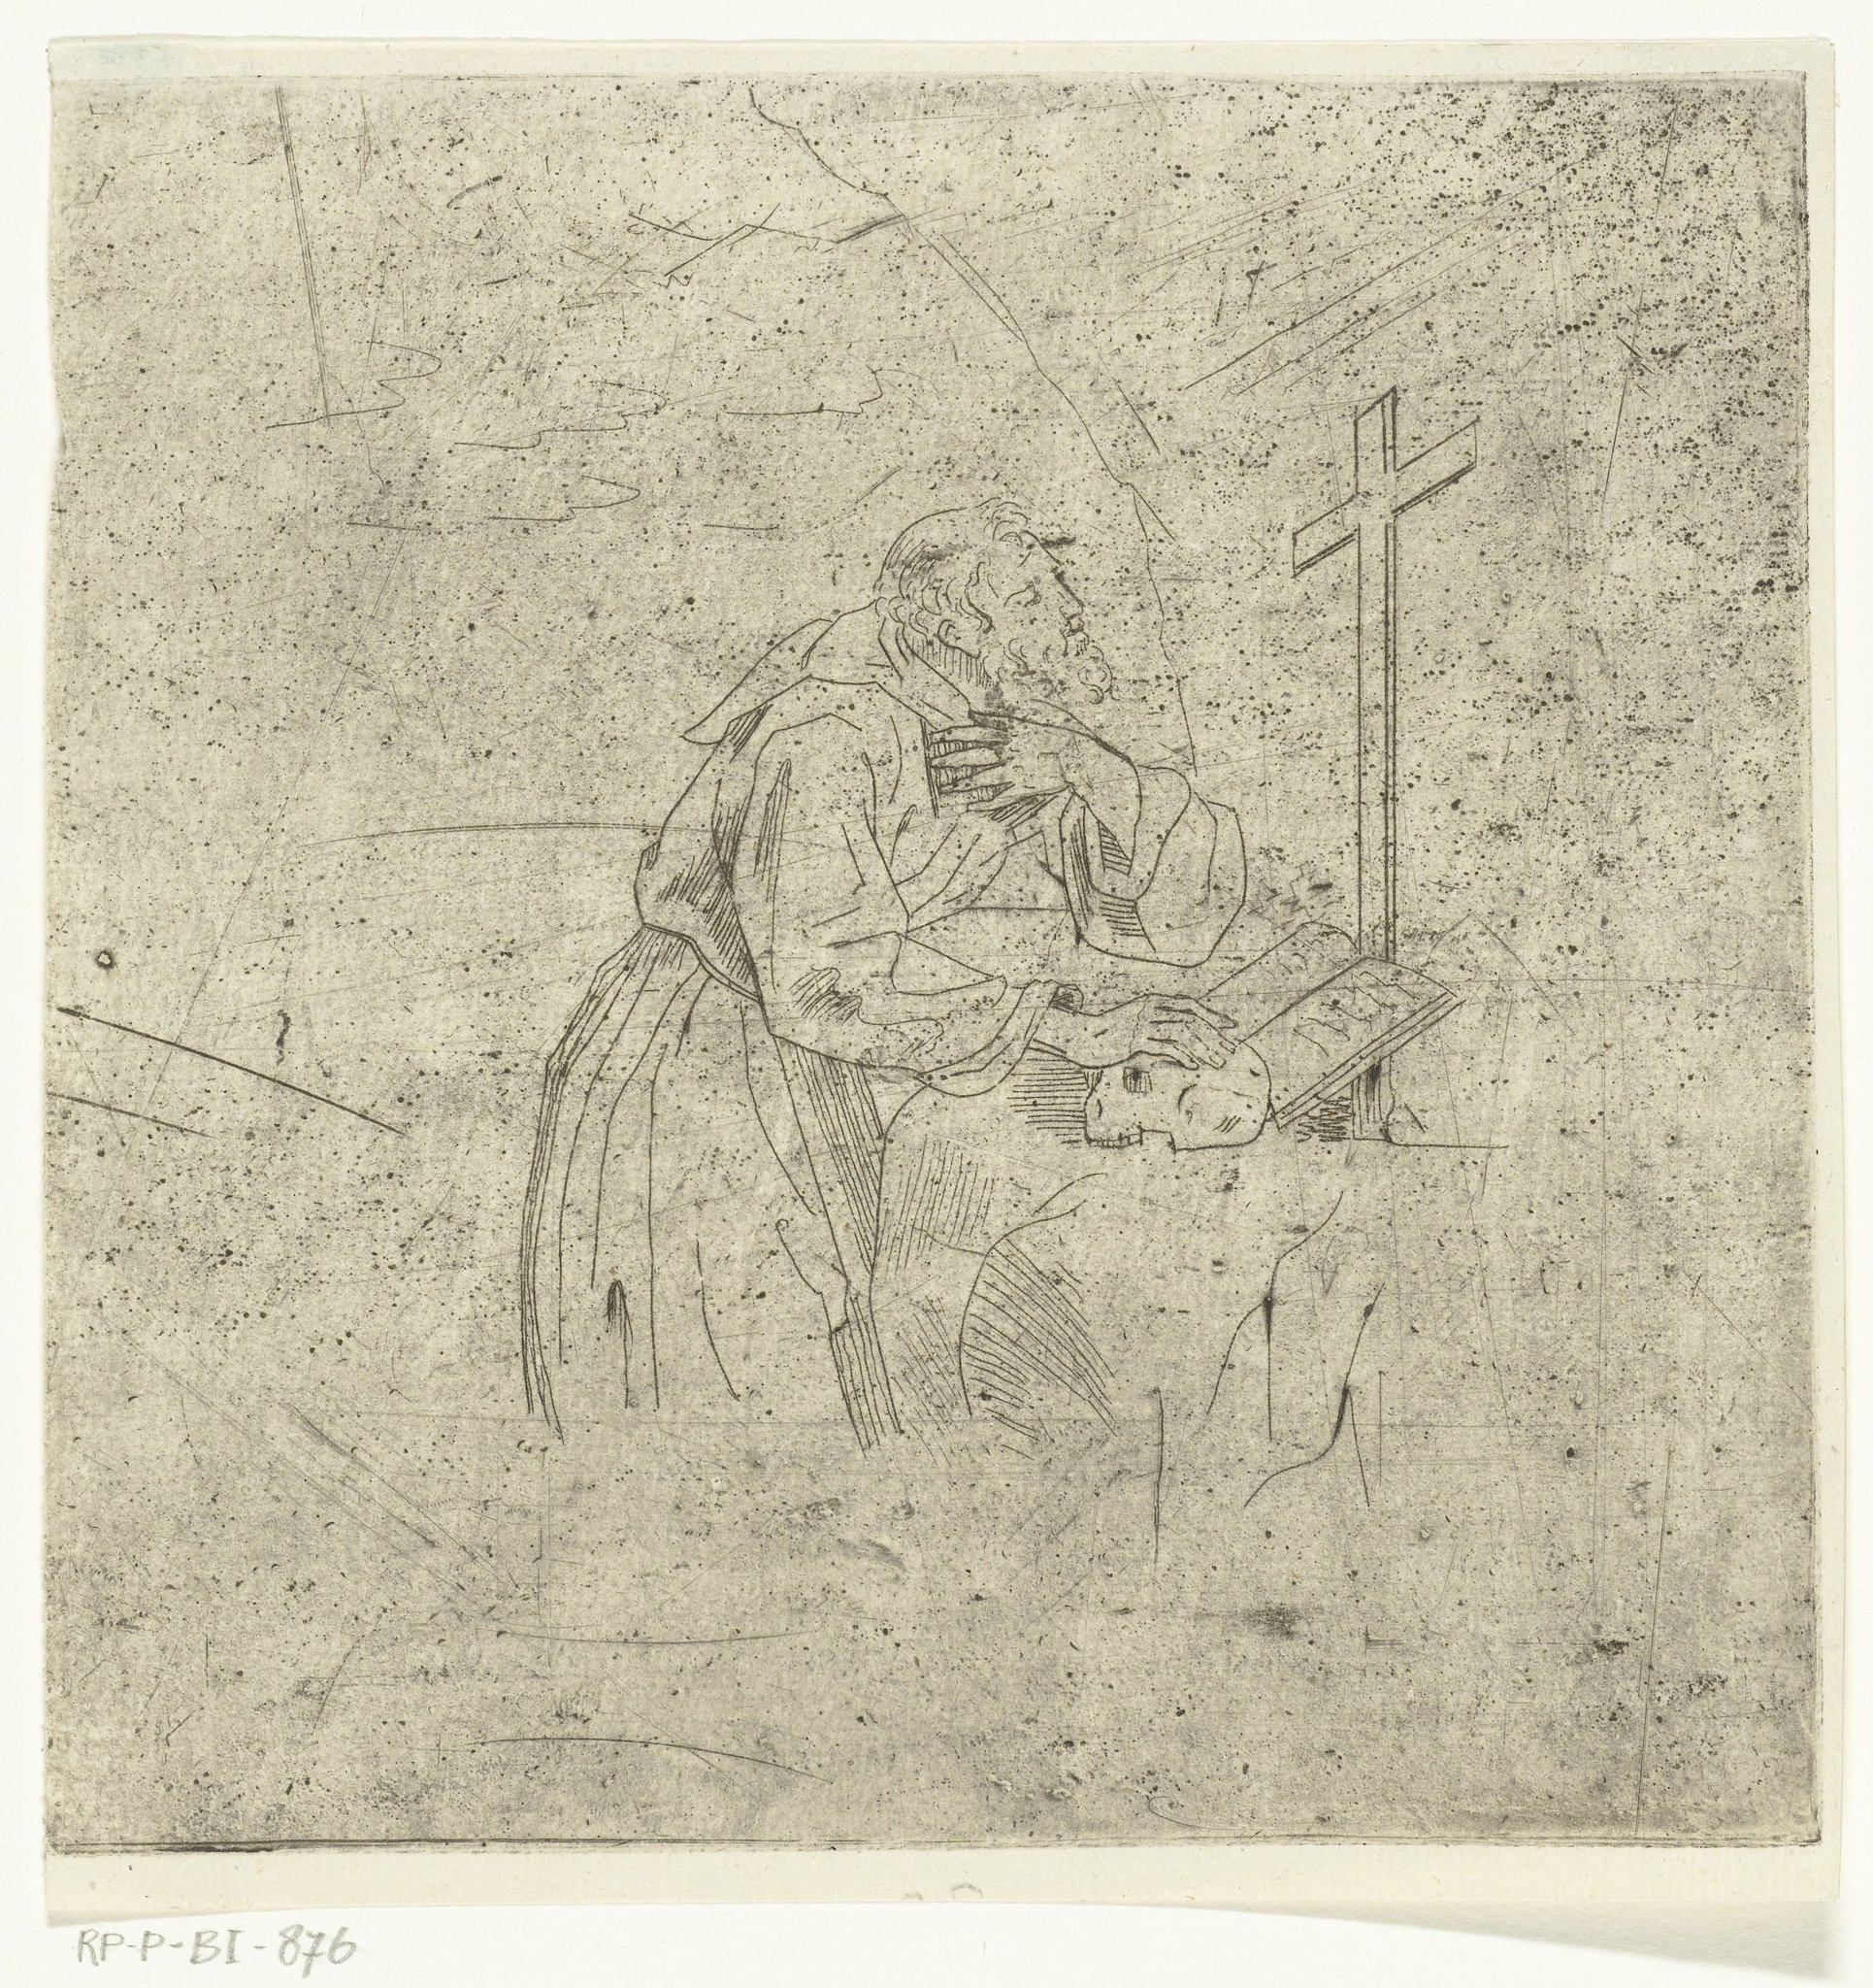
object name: print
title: Heilige Hieronymus als boeteling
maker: jonkheer isaac lambertus cremer van den berch van heemstede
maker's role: print maker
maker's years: 1811-1879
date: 1821-1879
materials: paper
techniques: etching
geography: netherlands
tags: the monk and hermit jerome (hieronymus); possible attributes: book, cardinal's hat, crucifix, hour-glass, lion, skull, stone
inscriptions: collector's mark: Lugt 2228